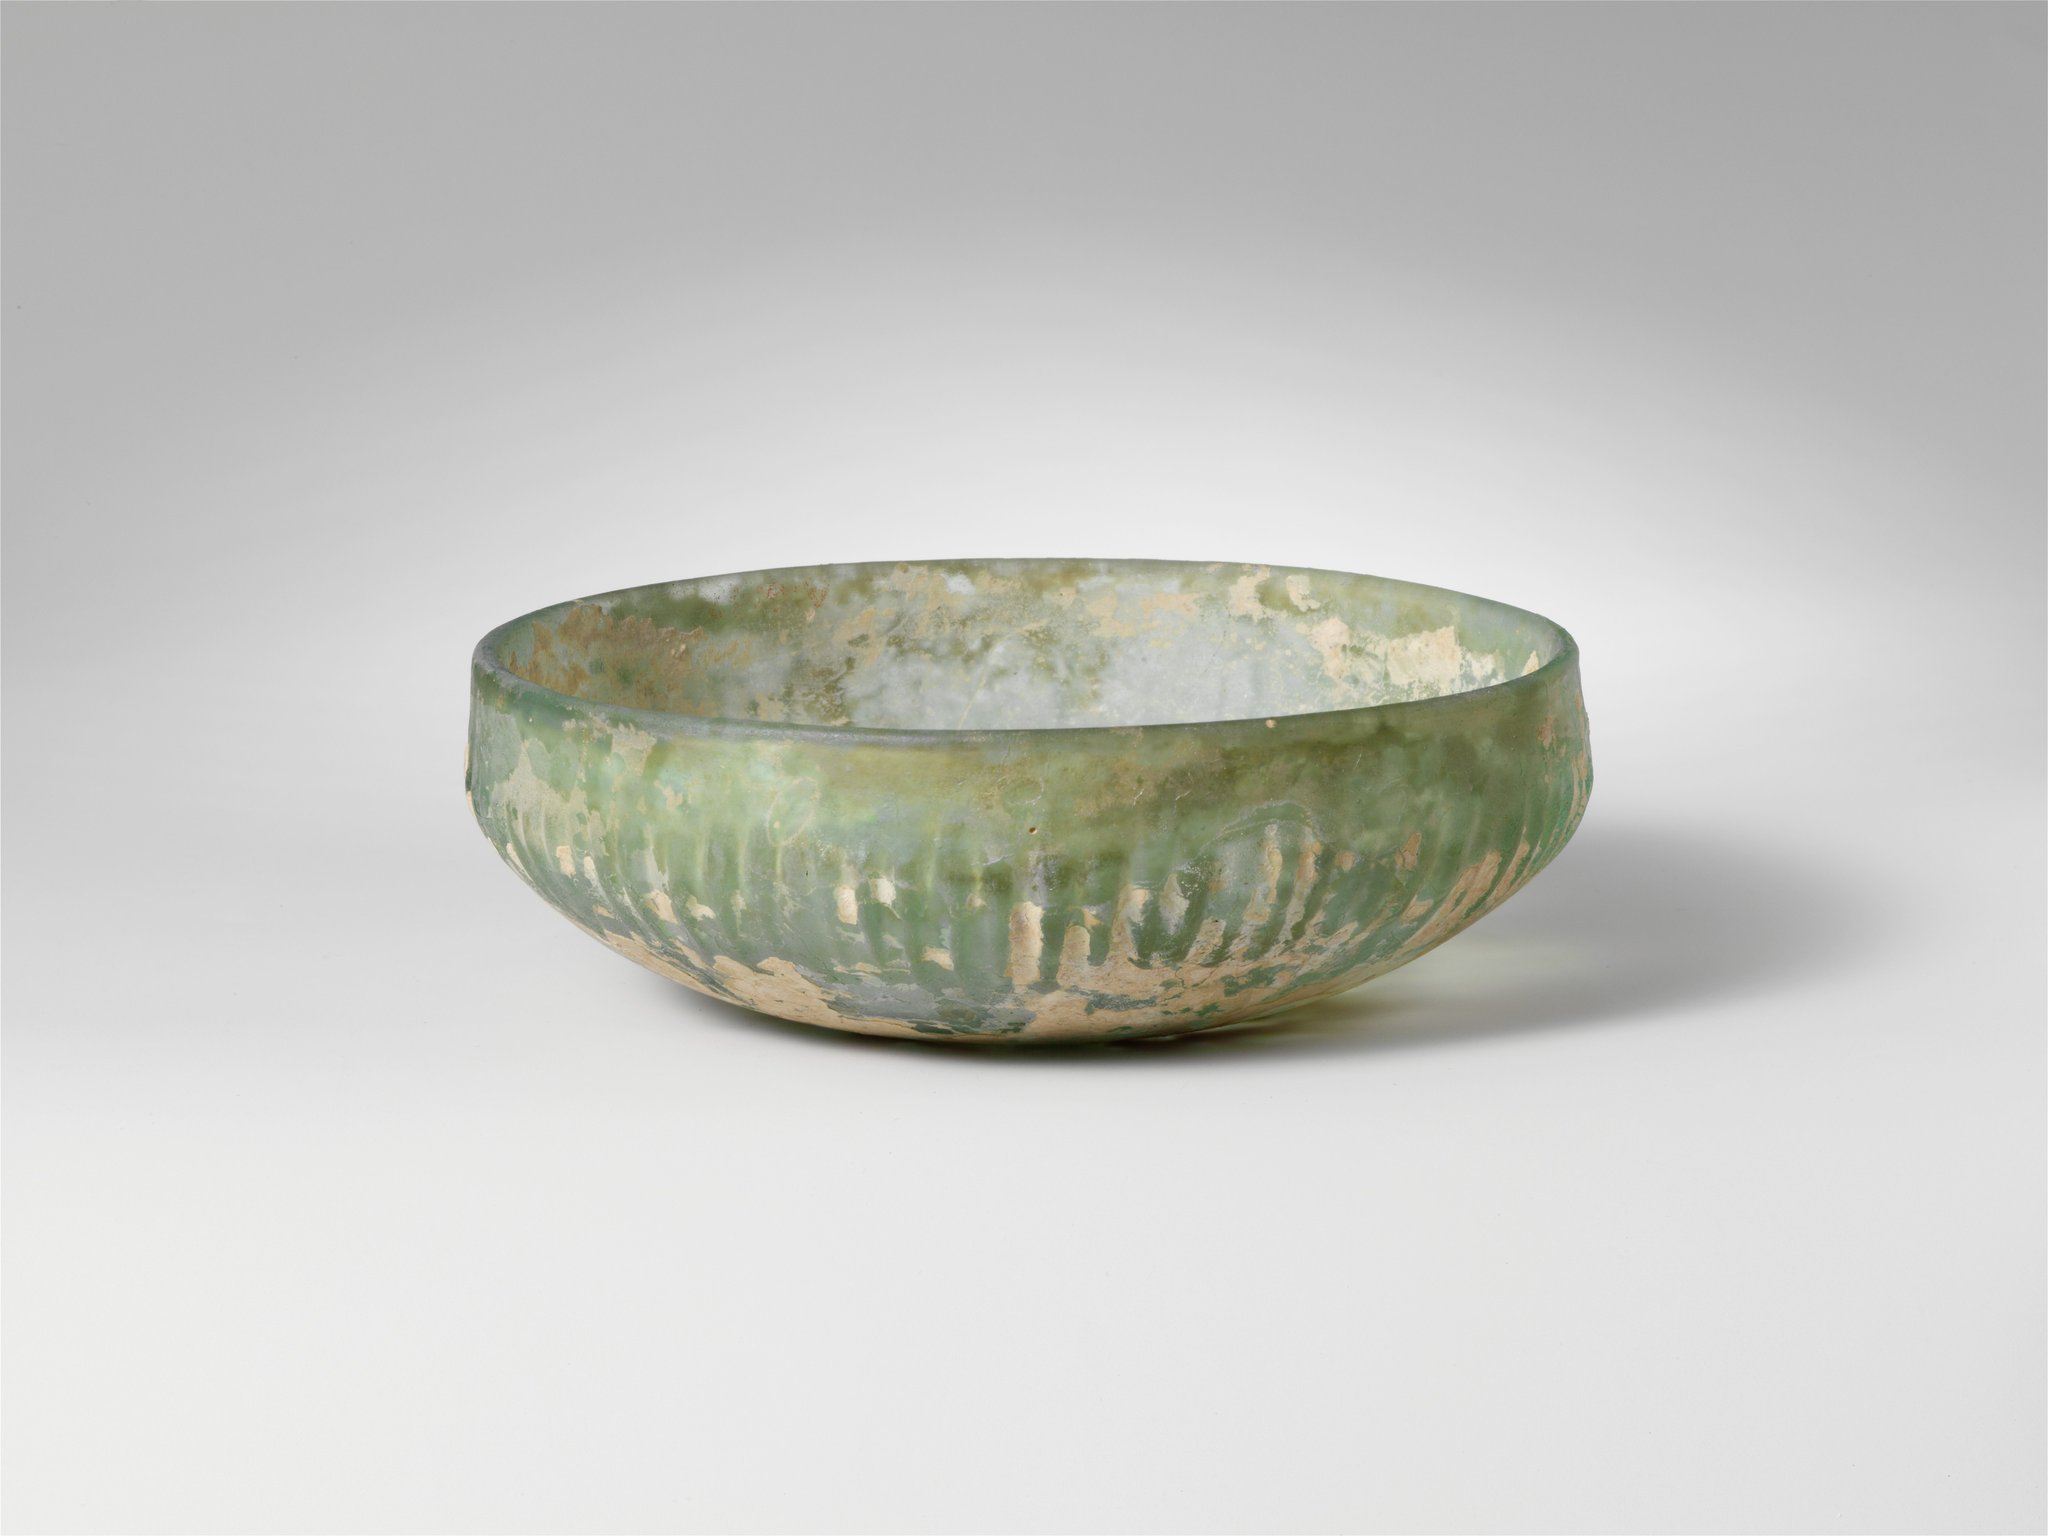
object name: bowl, ribbed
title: Glass ribbed bowl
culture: roman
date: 34 BCE-66 CE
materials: glass